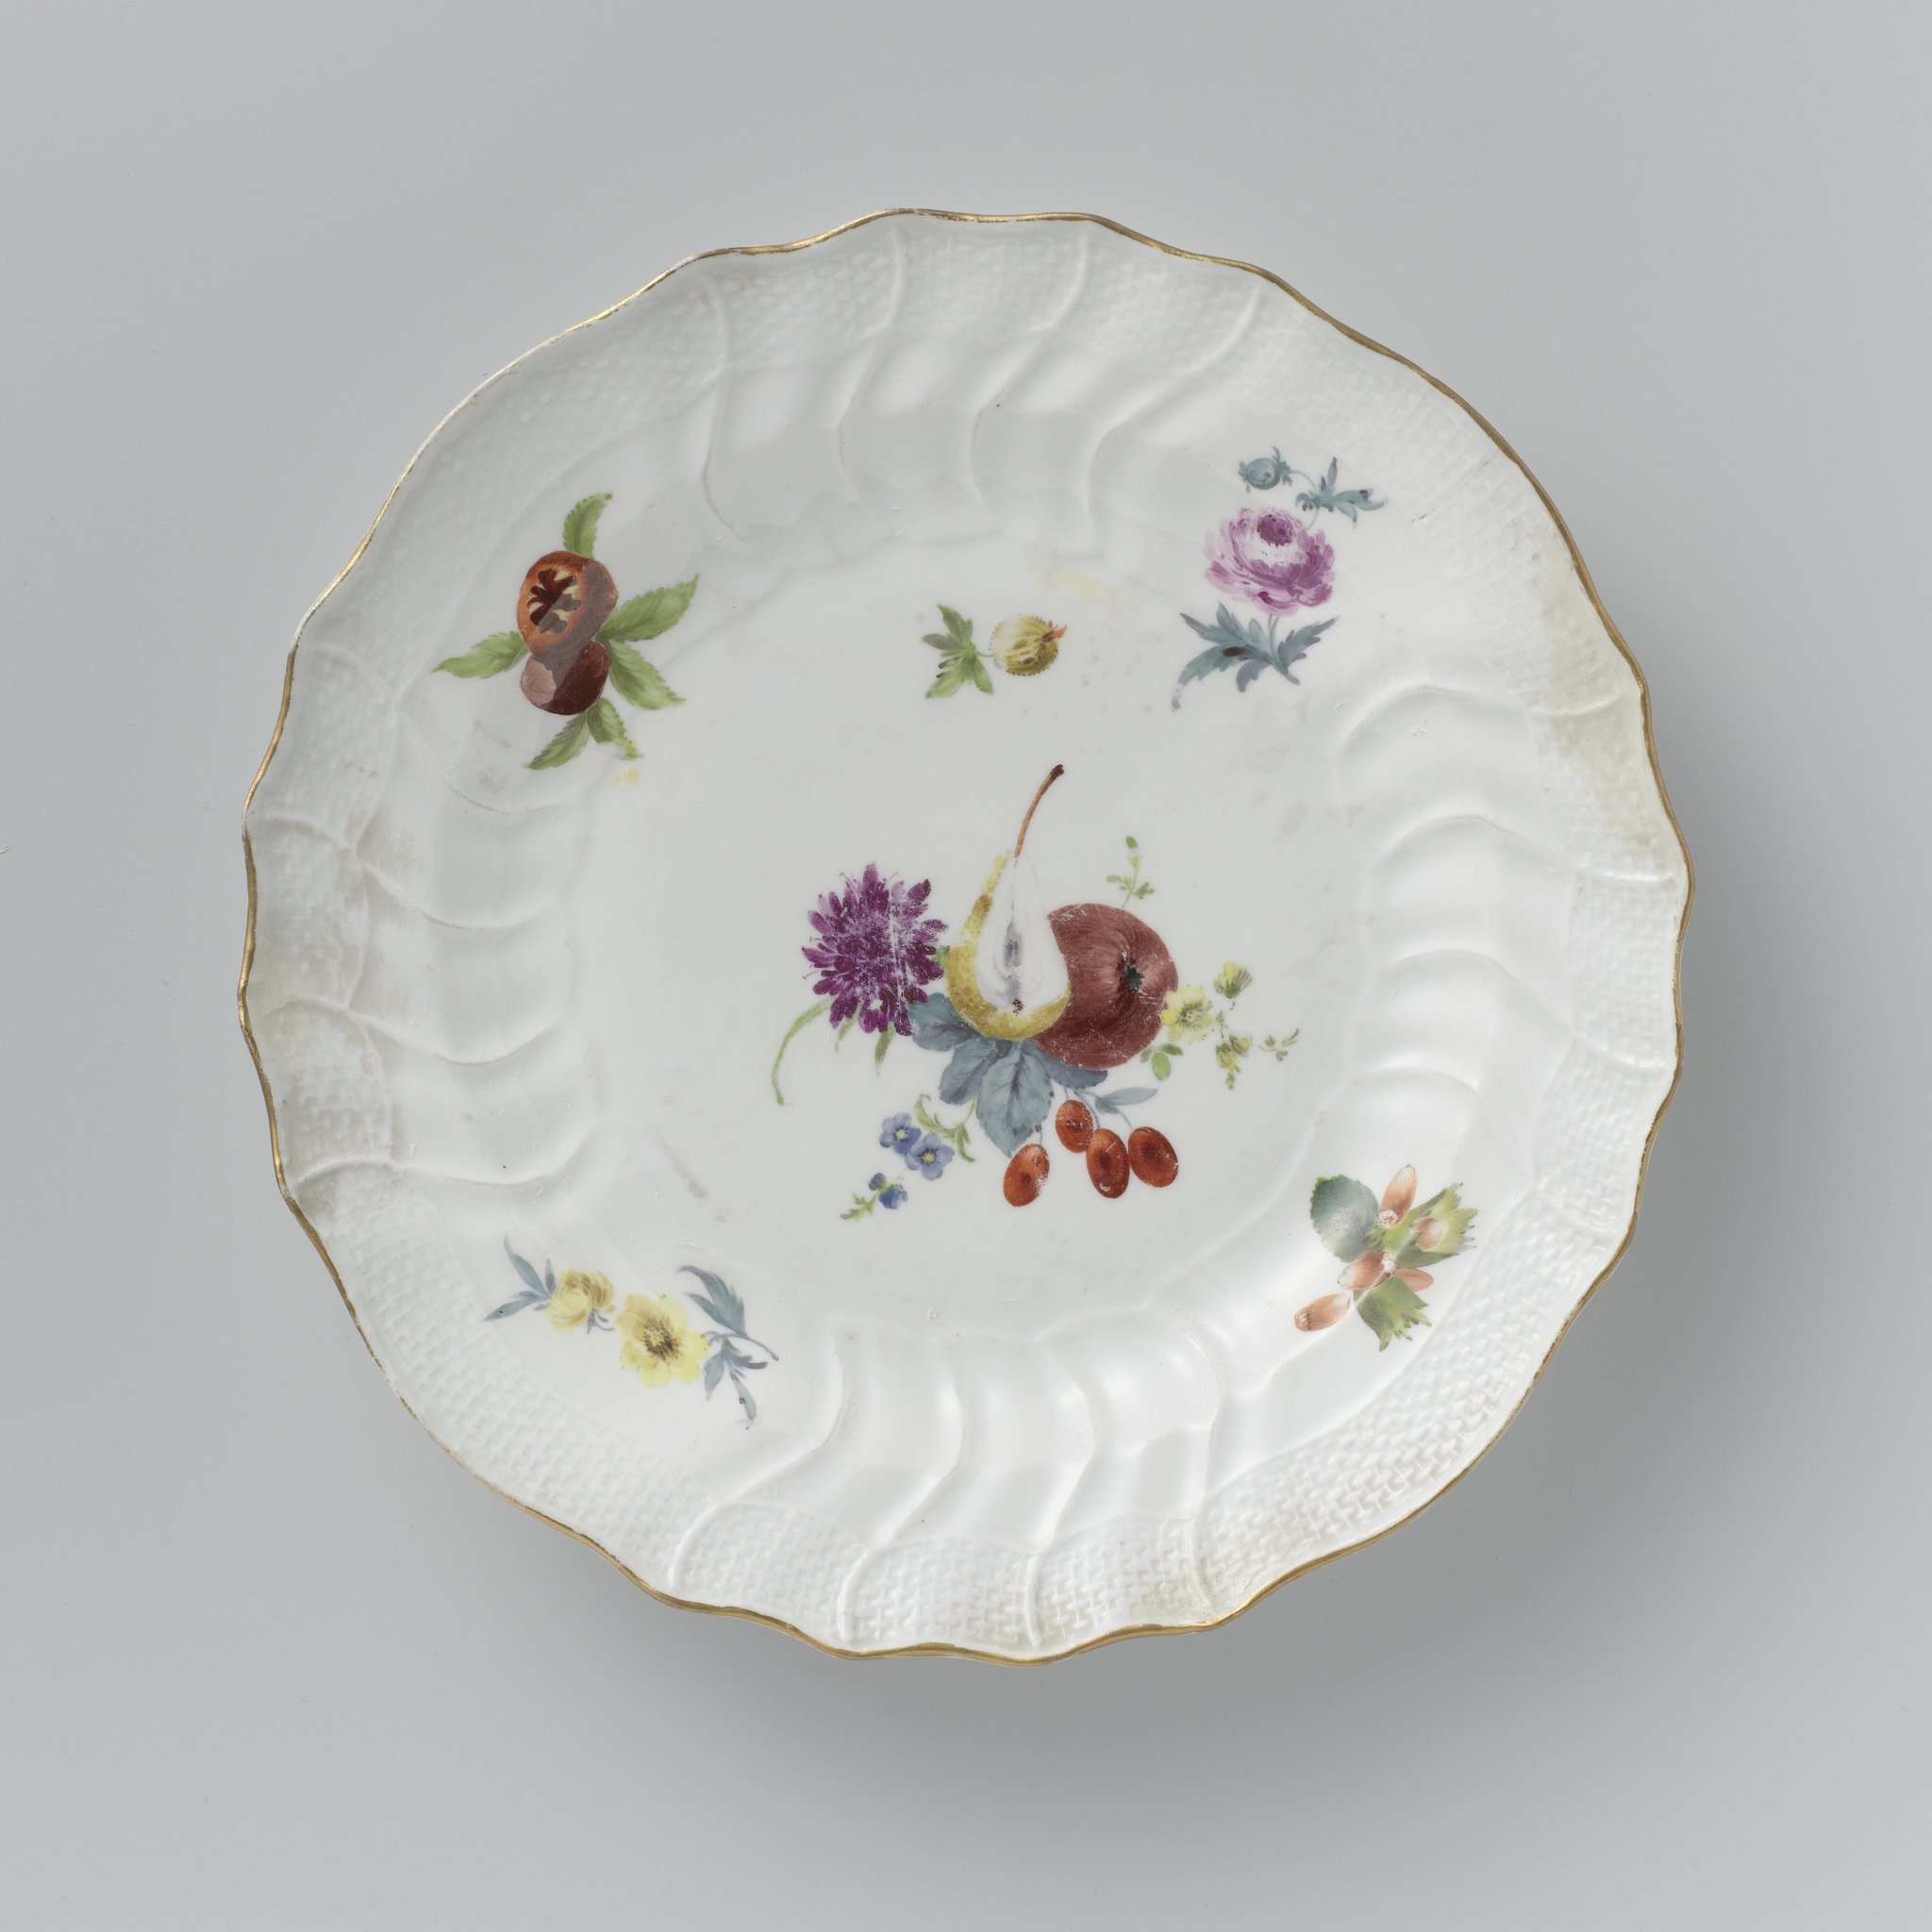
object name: eating drinking utensil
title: Bord, veelkleurig beschilderd met Deutsche Blumen, insekten en vruchten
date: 1750-1760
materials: porcelain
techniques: painted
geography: meissen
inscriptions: factory mark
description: Rond bord van beschilderd porselein. Het bord is beschilderd met Deutsche Blumen, insekten en vruchten. De rand is in reliëf versierd met het Neuozier-patroon. Het bord is gemerkt en hoort bij een servies (BK-17474-1 t/m BK-17474-253).